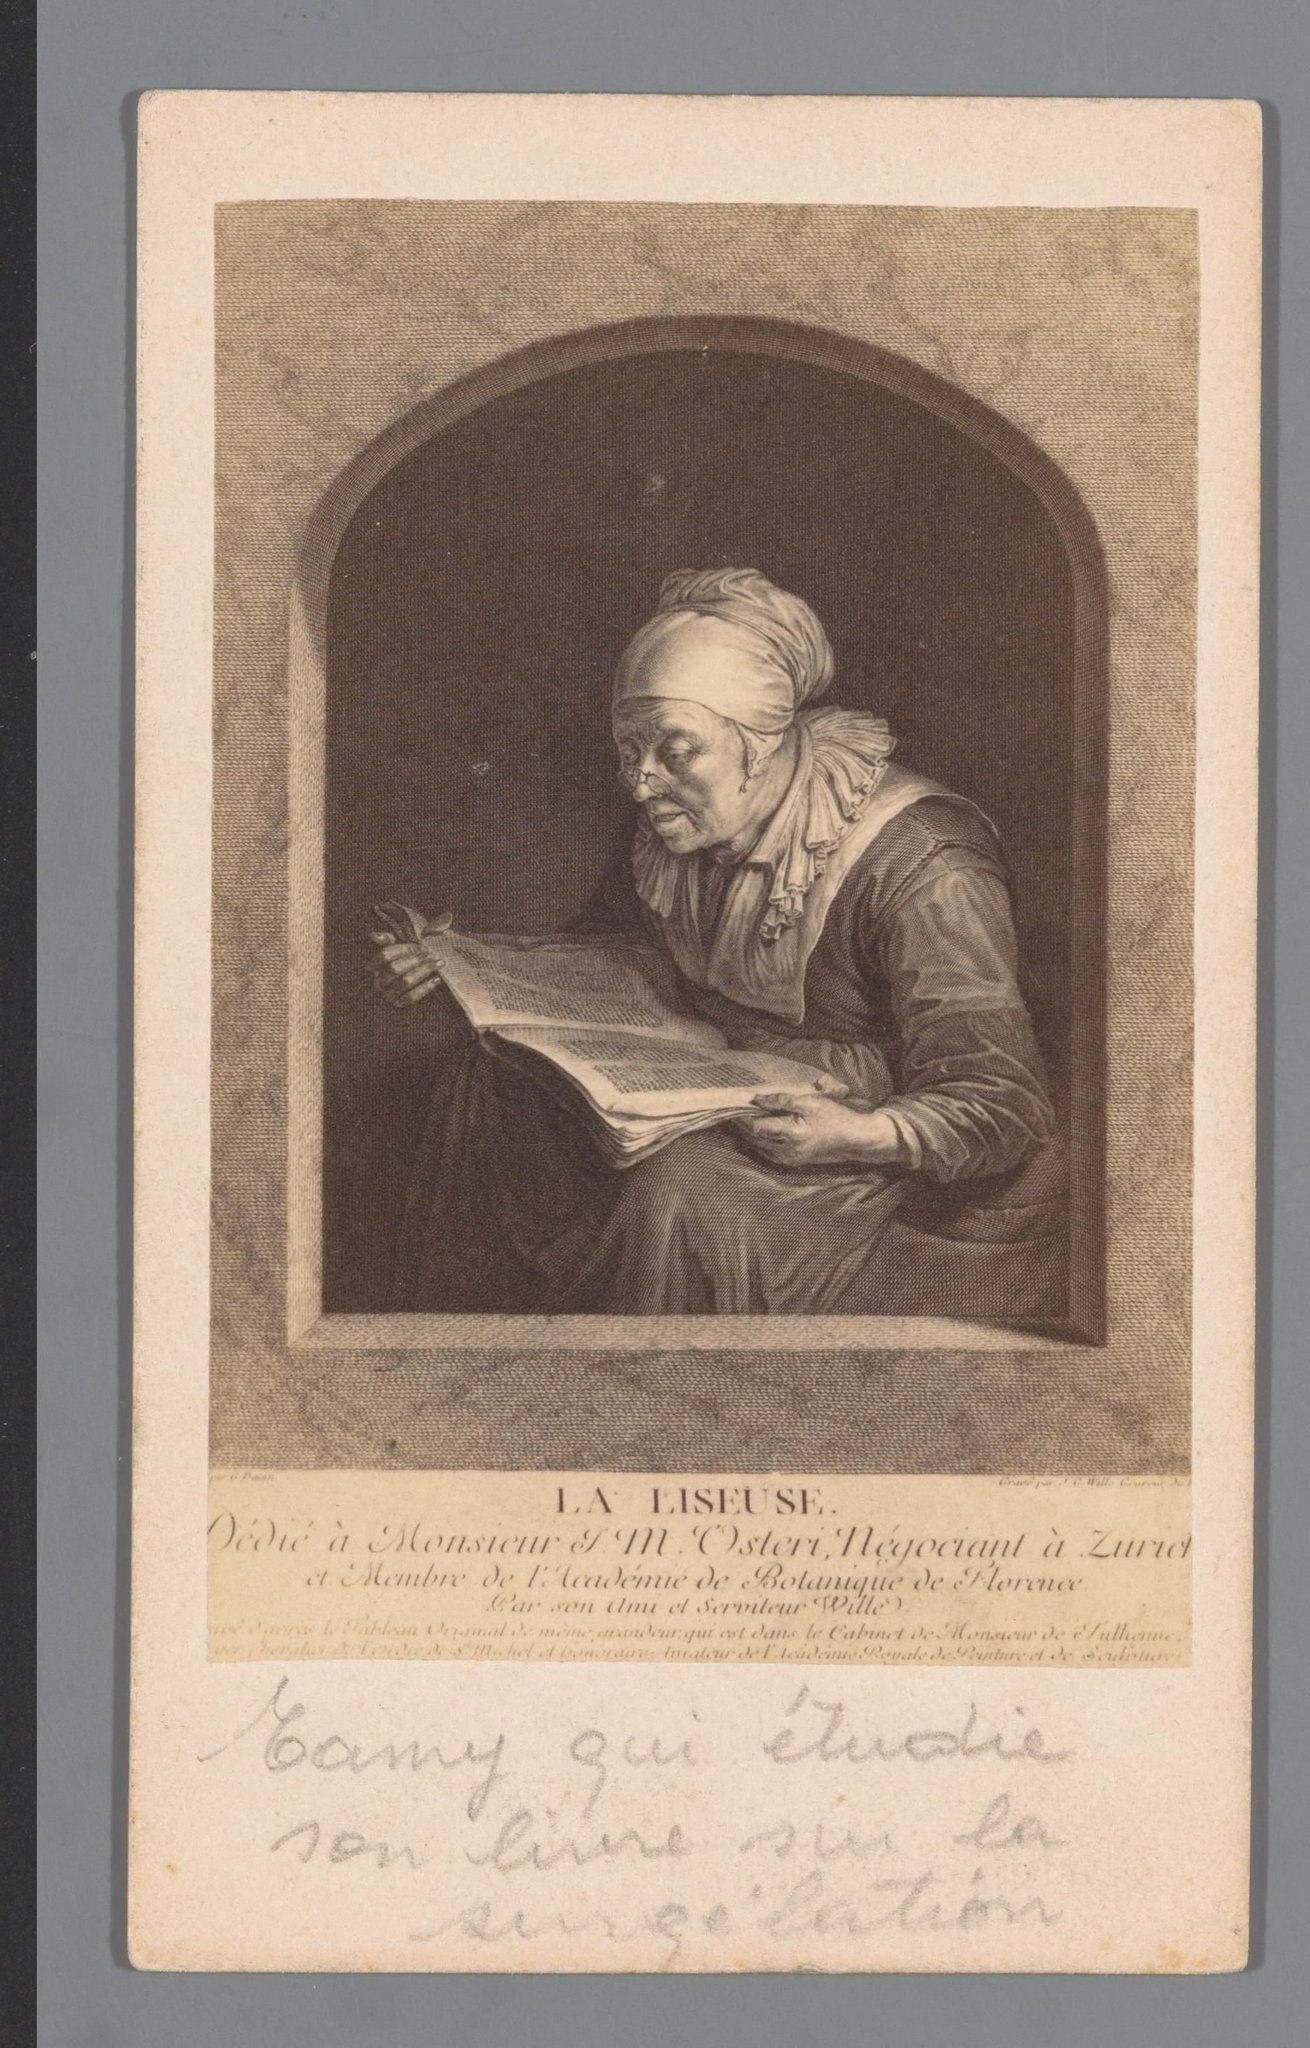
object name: photograph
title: Fotoreproductie van een gravure naar een schilderij van een lezende vrouw, door Gerard Dou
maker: Anonymous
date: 1850-1900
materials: cardboard, photographic support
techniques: albumen print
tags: adult woman, reading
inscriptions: annotation: ‘[.]amy qui étudie / son livre sur la / surgélation’, number: ‘50-’